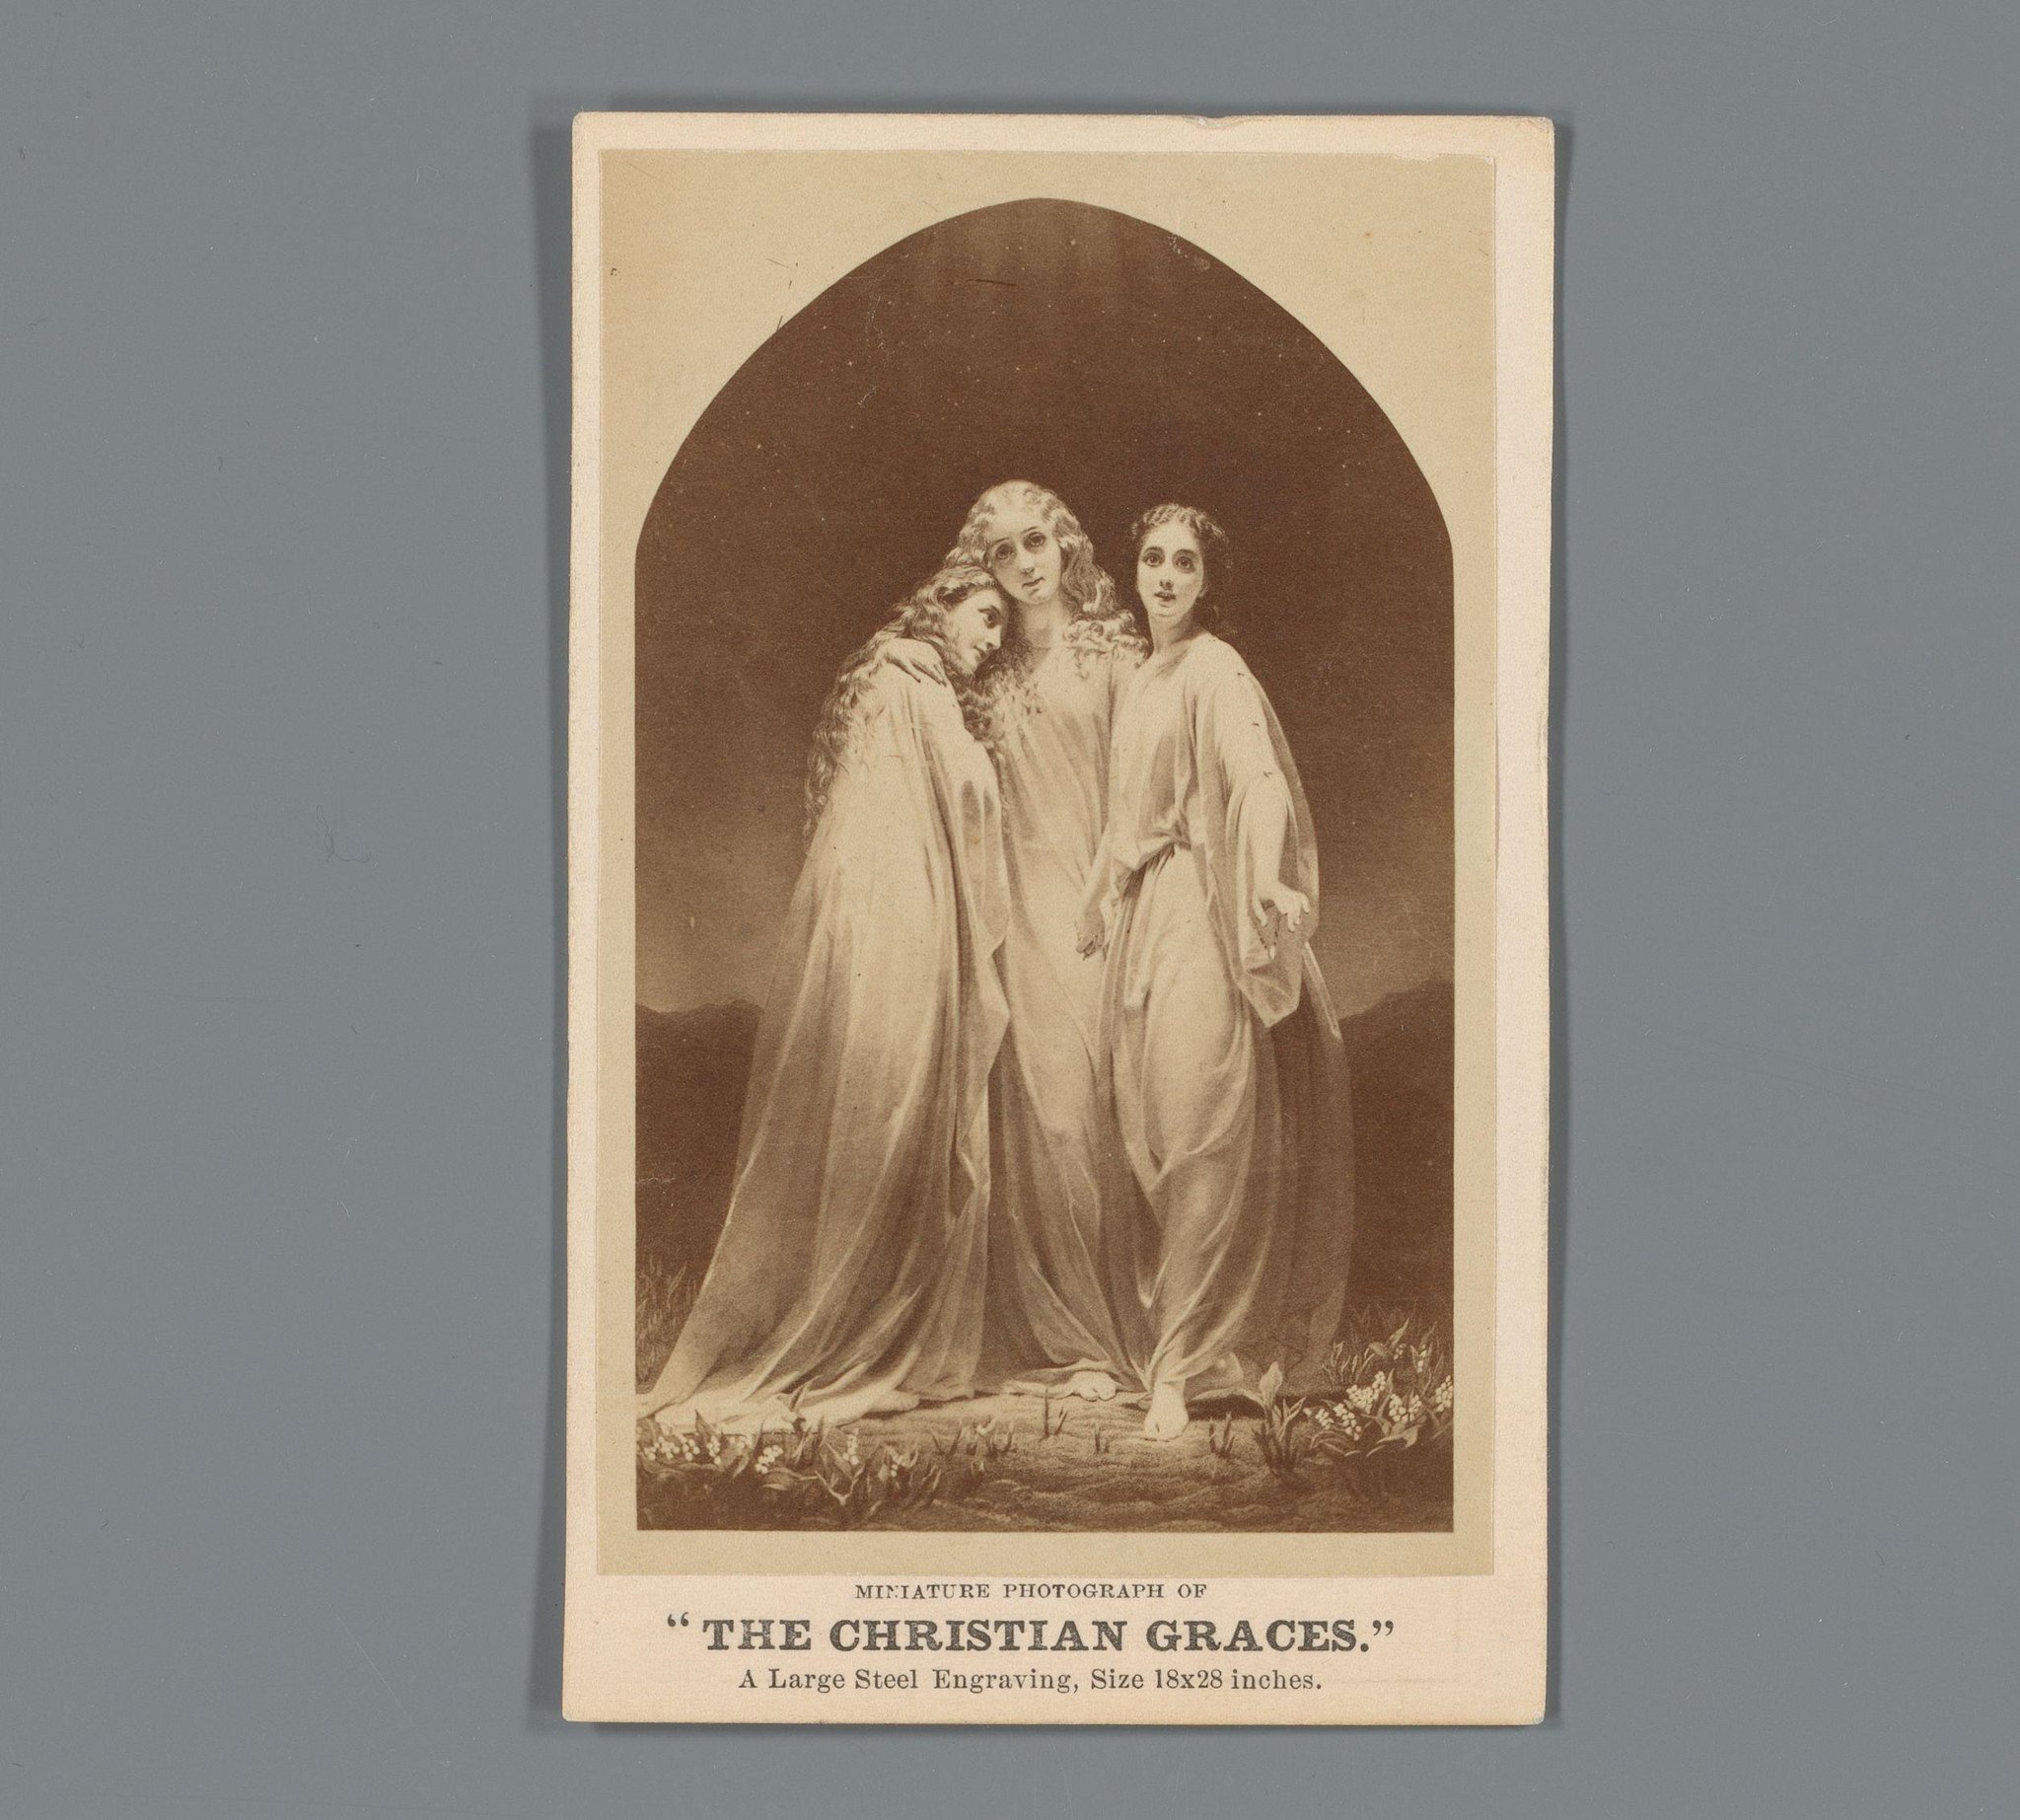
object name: photograph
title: Miniature photograph of the Christian Graces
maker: Anonymous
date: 1873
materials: cardboard, photographic support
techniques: albumen print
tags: weekly, monthly, magazine, etc., advertising, graces (charites), generally three in number; 'gratie' (ripa)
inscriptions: inscription: ‘ARTHUR'S/ Illustrated Home Magazine/ THE GREAT HOUSEHOLD MAGAZINE OF AMERICA./ (...)/ T.S. ARTHUR & SON, Philadelphia, Pa.’, inscription: ‘A Large Steel Engraving, Size 18x28 inches.’